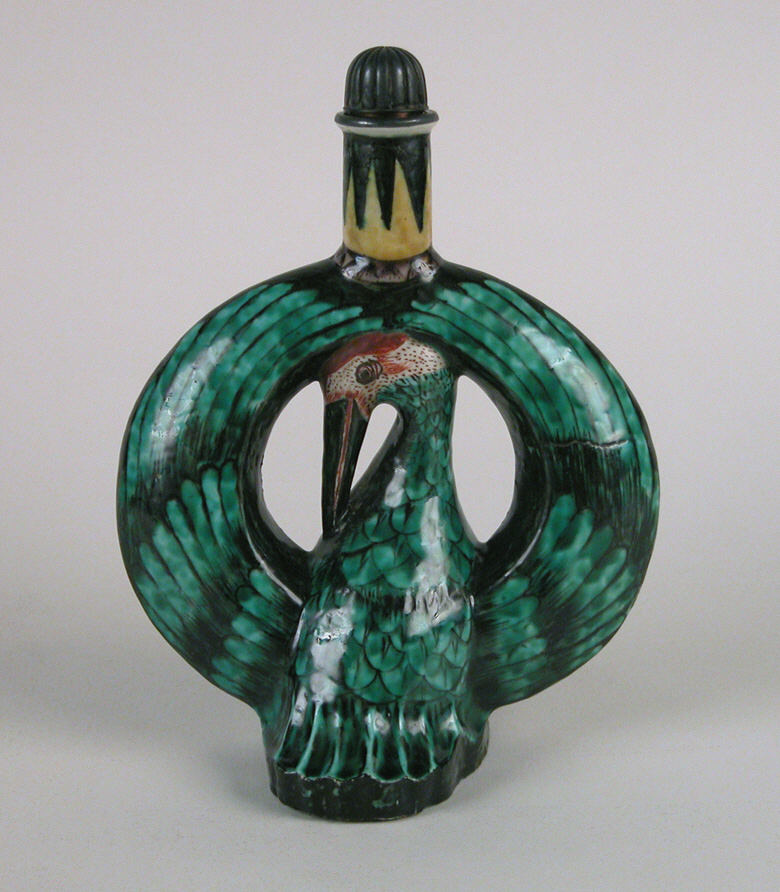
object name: wine bottle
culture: japanese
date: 1720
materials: enamel, porcelain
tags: birds